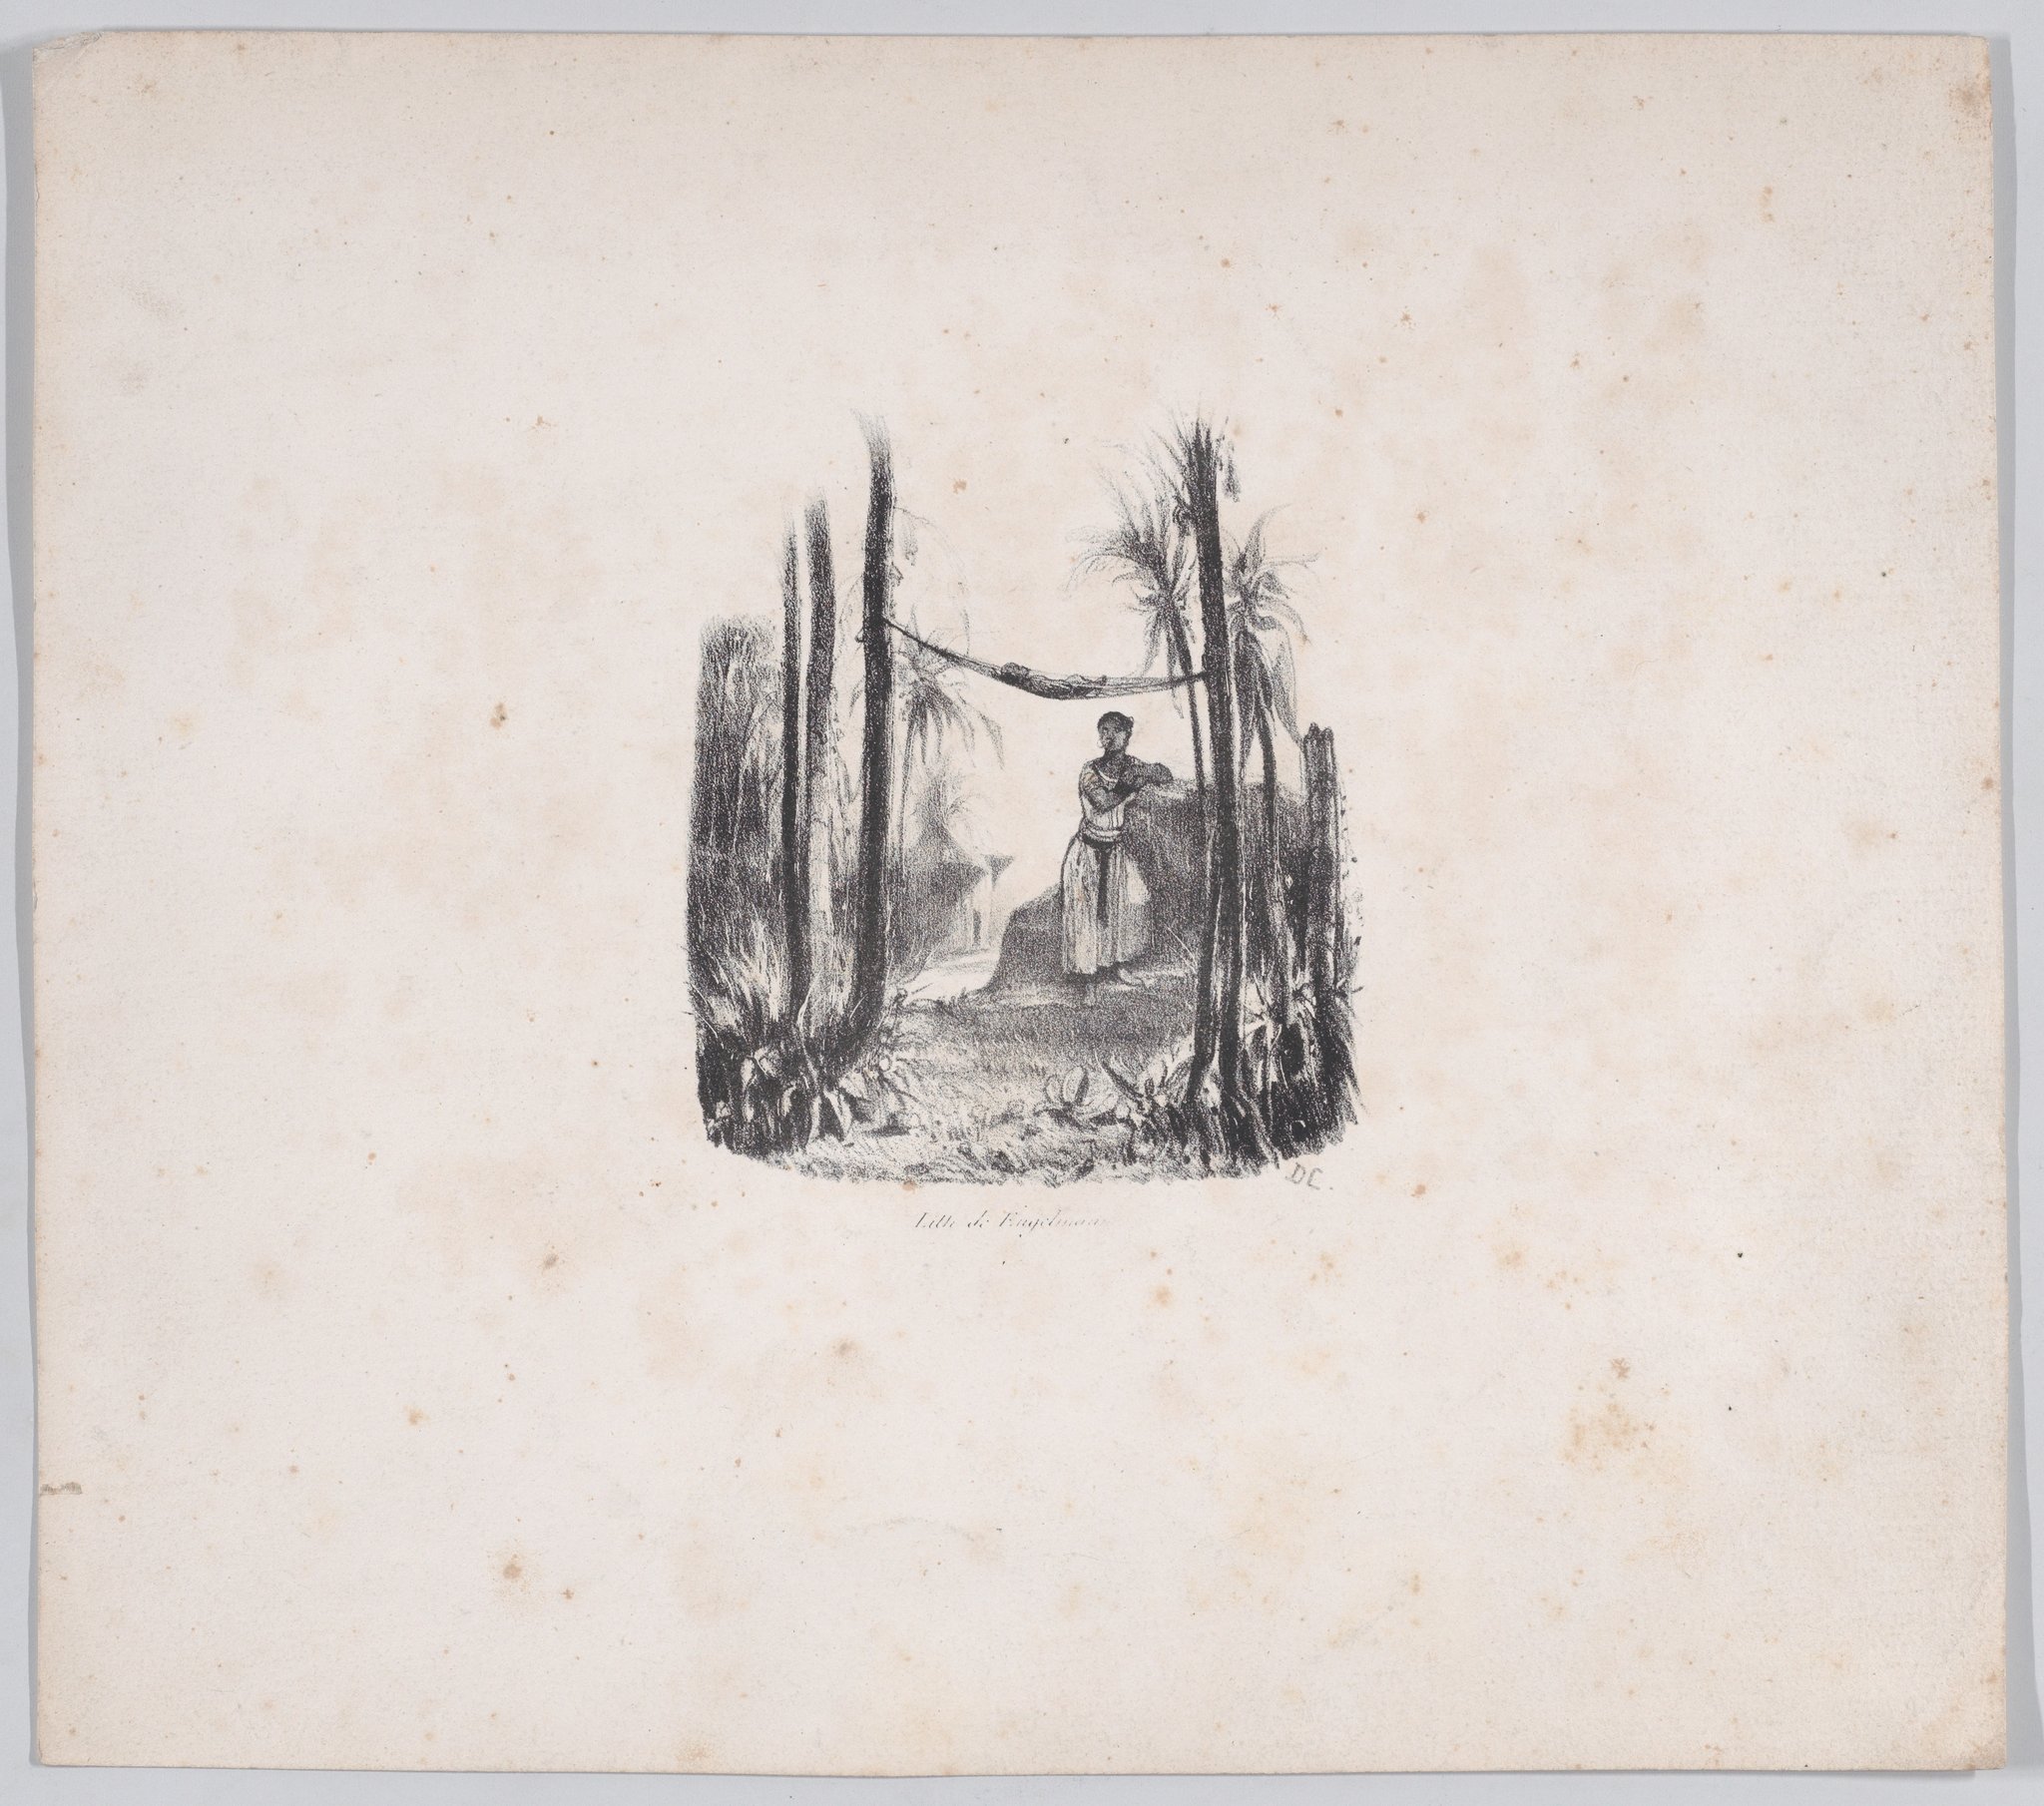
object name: print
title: An Indian Woman and Her Son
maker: alexandre-gabriel decamps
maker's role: artist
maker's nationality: french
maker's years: 1803-1860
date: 1830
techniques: lithograph